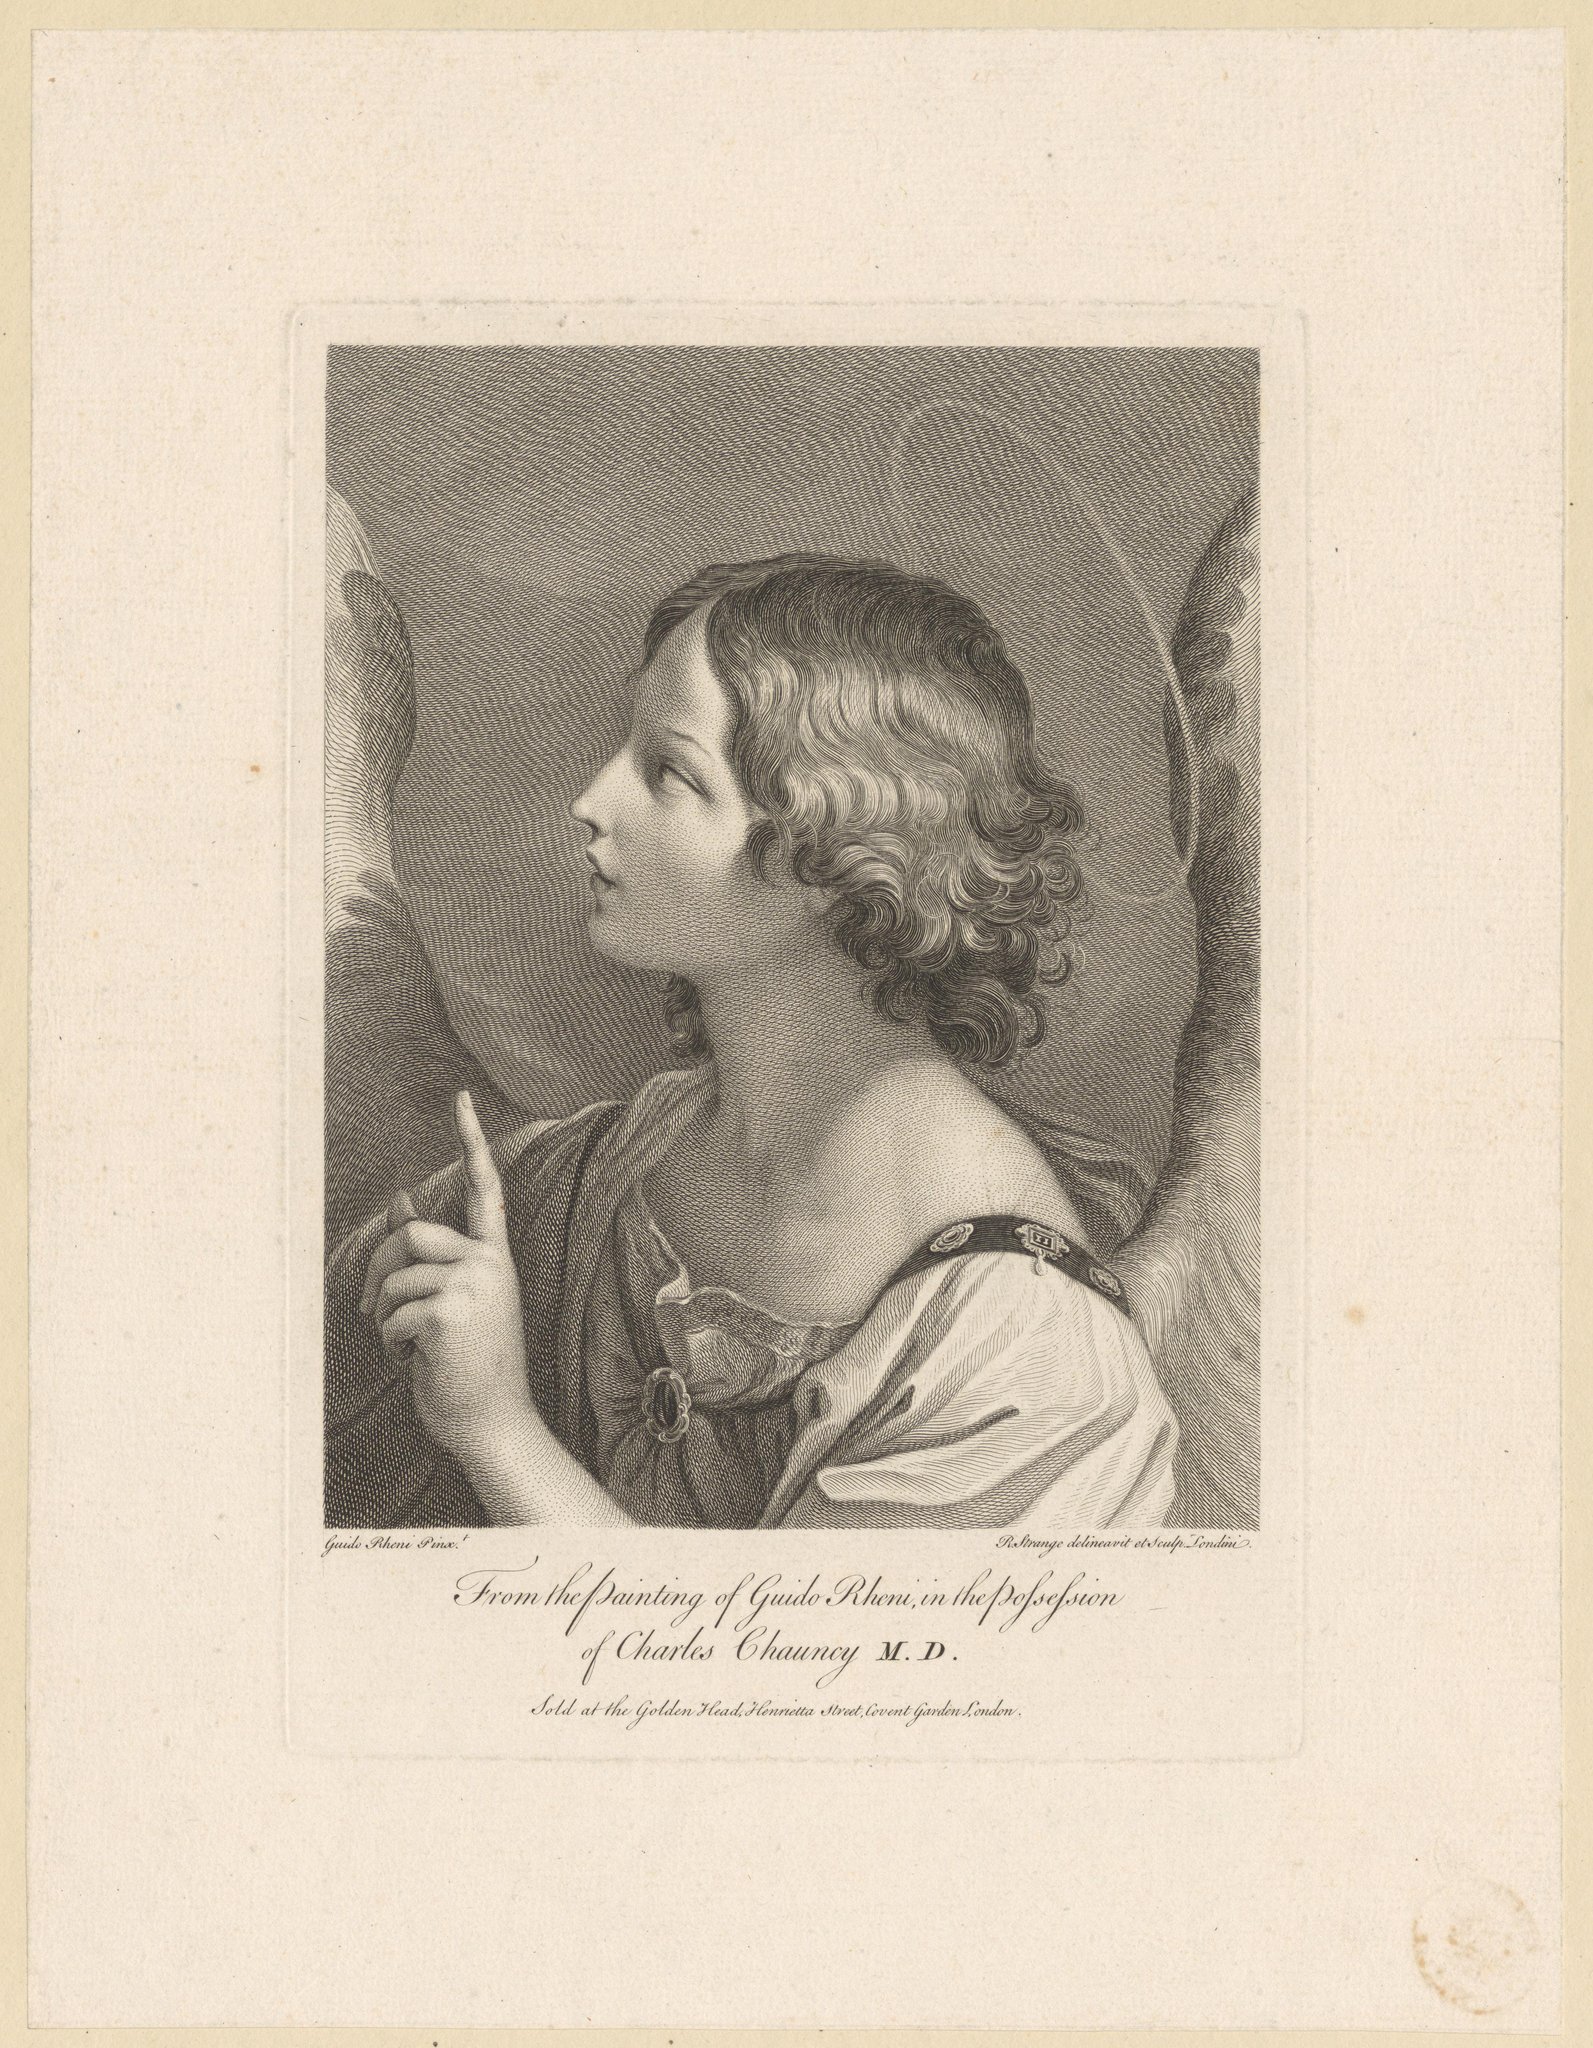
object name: print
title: Buste van aartsengel Gabriël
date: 1765-1769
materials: paper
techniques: engraving, etching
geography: london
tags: the archangel gabriel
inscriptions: collector's mark: Lugt 240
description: De prent vormt een paar met RP-P-OB-19.023, Maria van de Annunciatie.